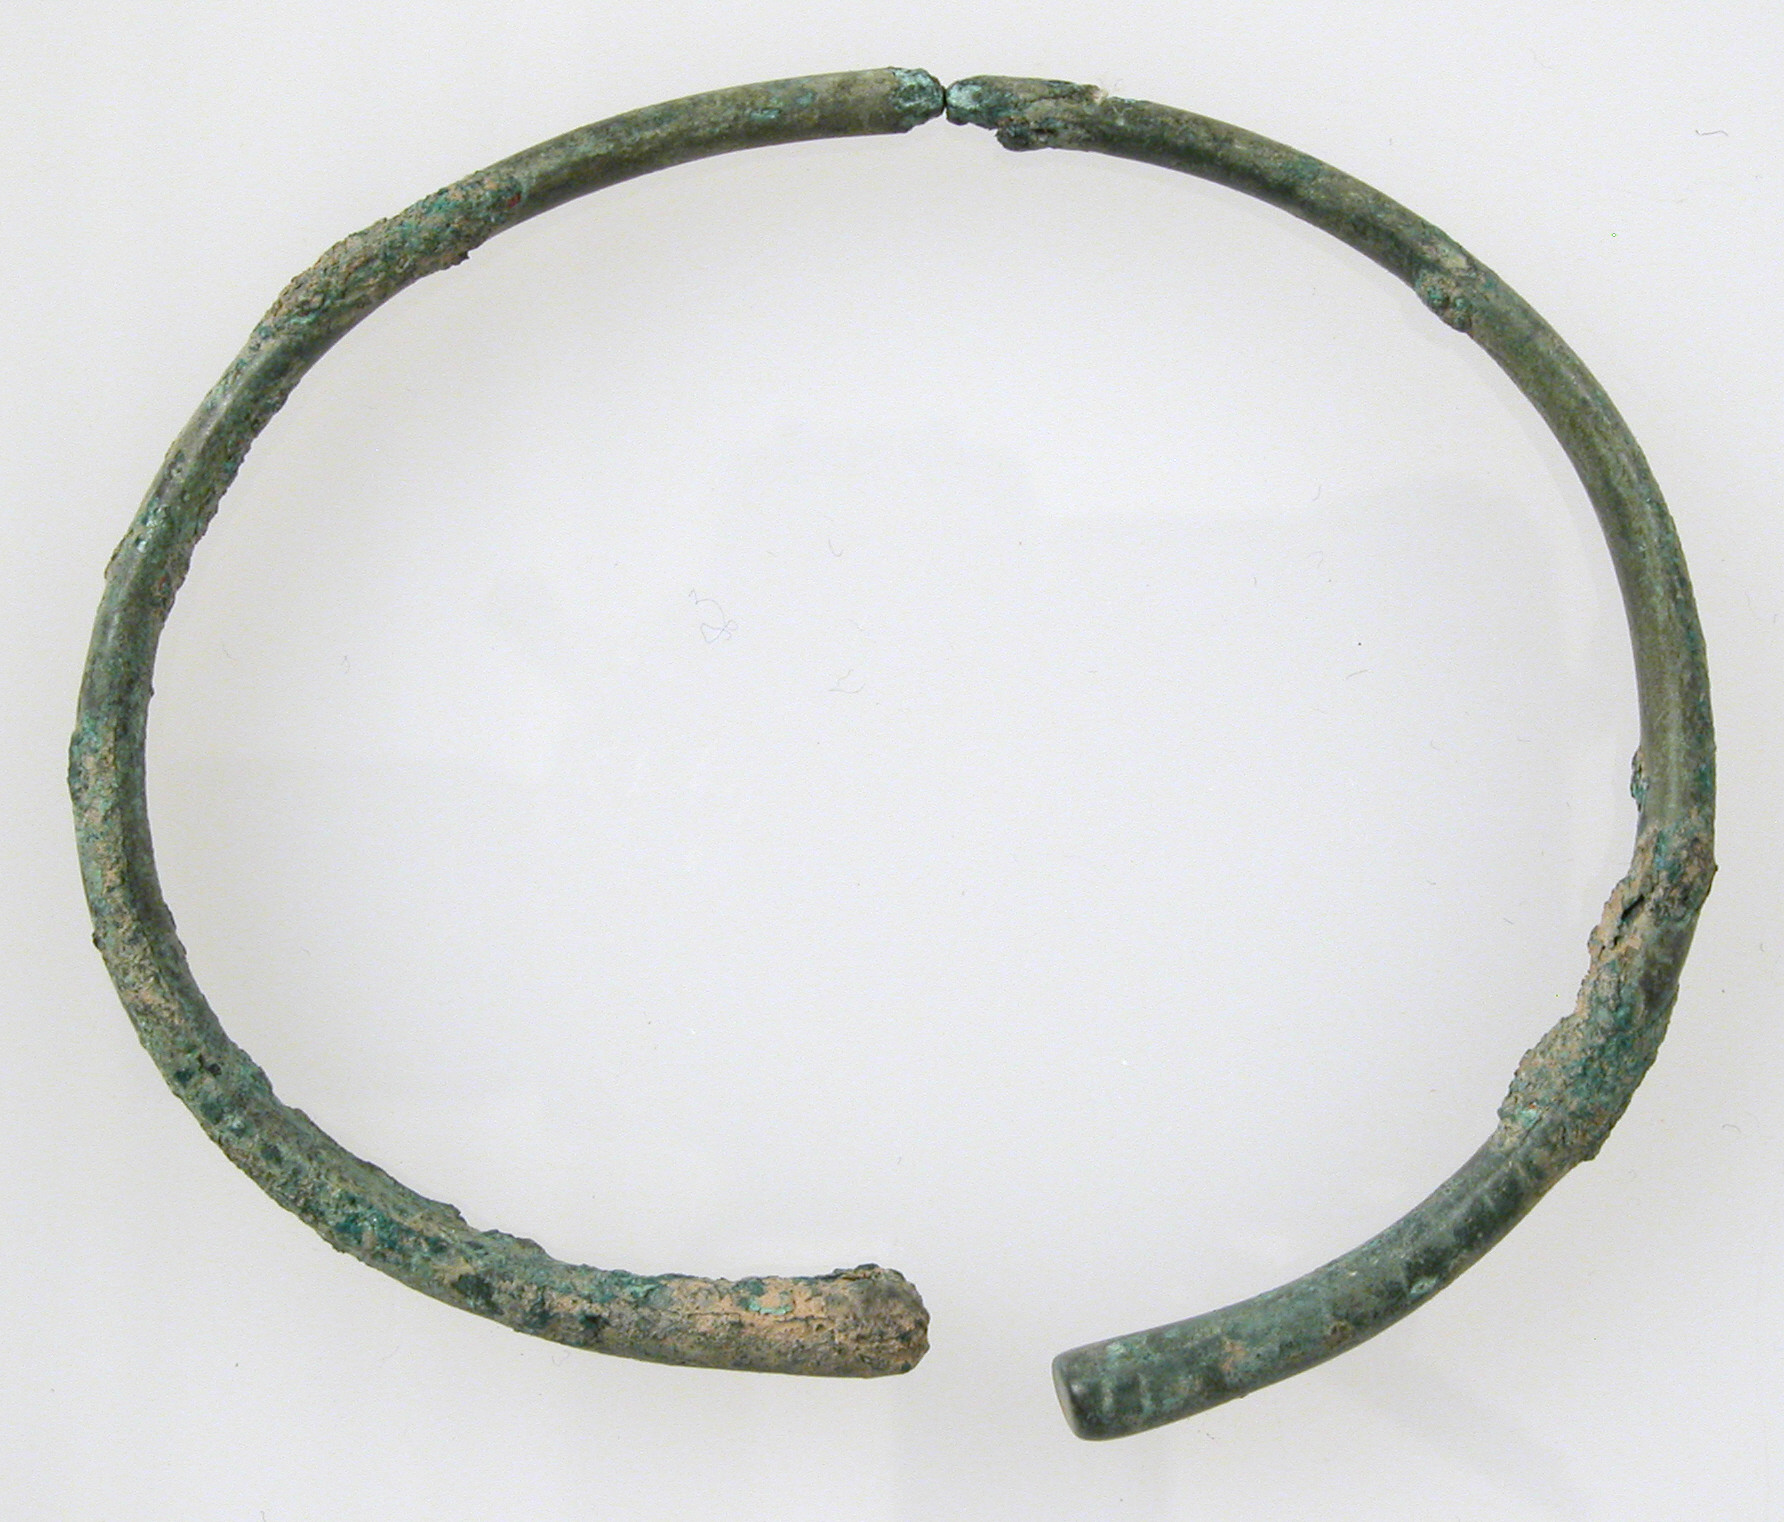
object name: armlet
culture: celtic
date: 400-100 BCE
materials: copper alloy